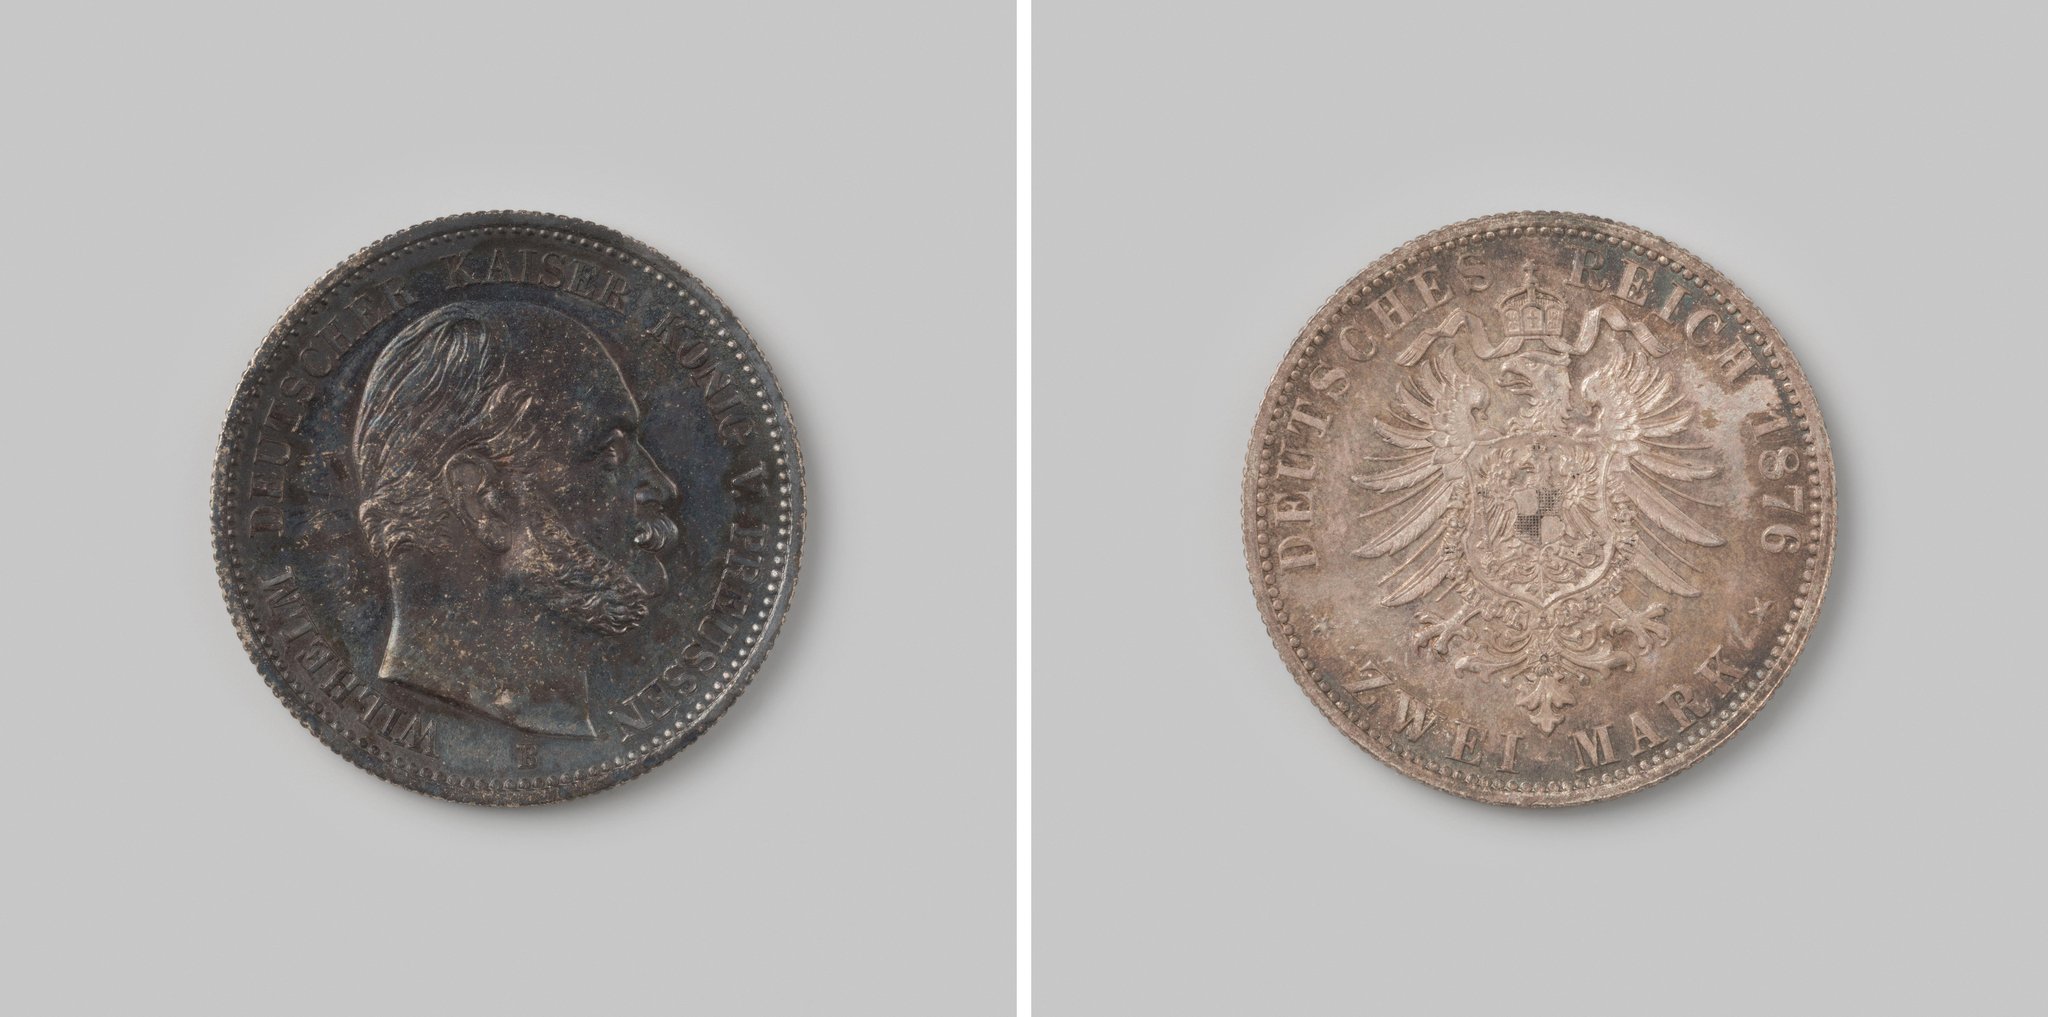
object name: coin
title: 2 Mark uit het Duitse Rijk, Pruisen van Wilhelm I, 1876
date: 1876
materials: silver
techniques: striking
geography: hannover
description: Zilveren munt. Voorzijde: hoofd van de keizer naar rechts. Daaronder letter B. Keerzijde: gekroonde enkelkoppige adelaar naar links met op borst door keten van orde met juweel omhangen samengesteld wapenschild. Daaronder waarde-aanduiding. Jaartal in omschrift. Kartelrand.